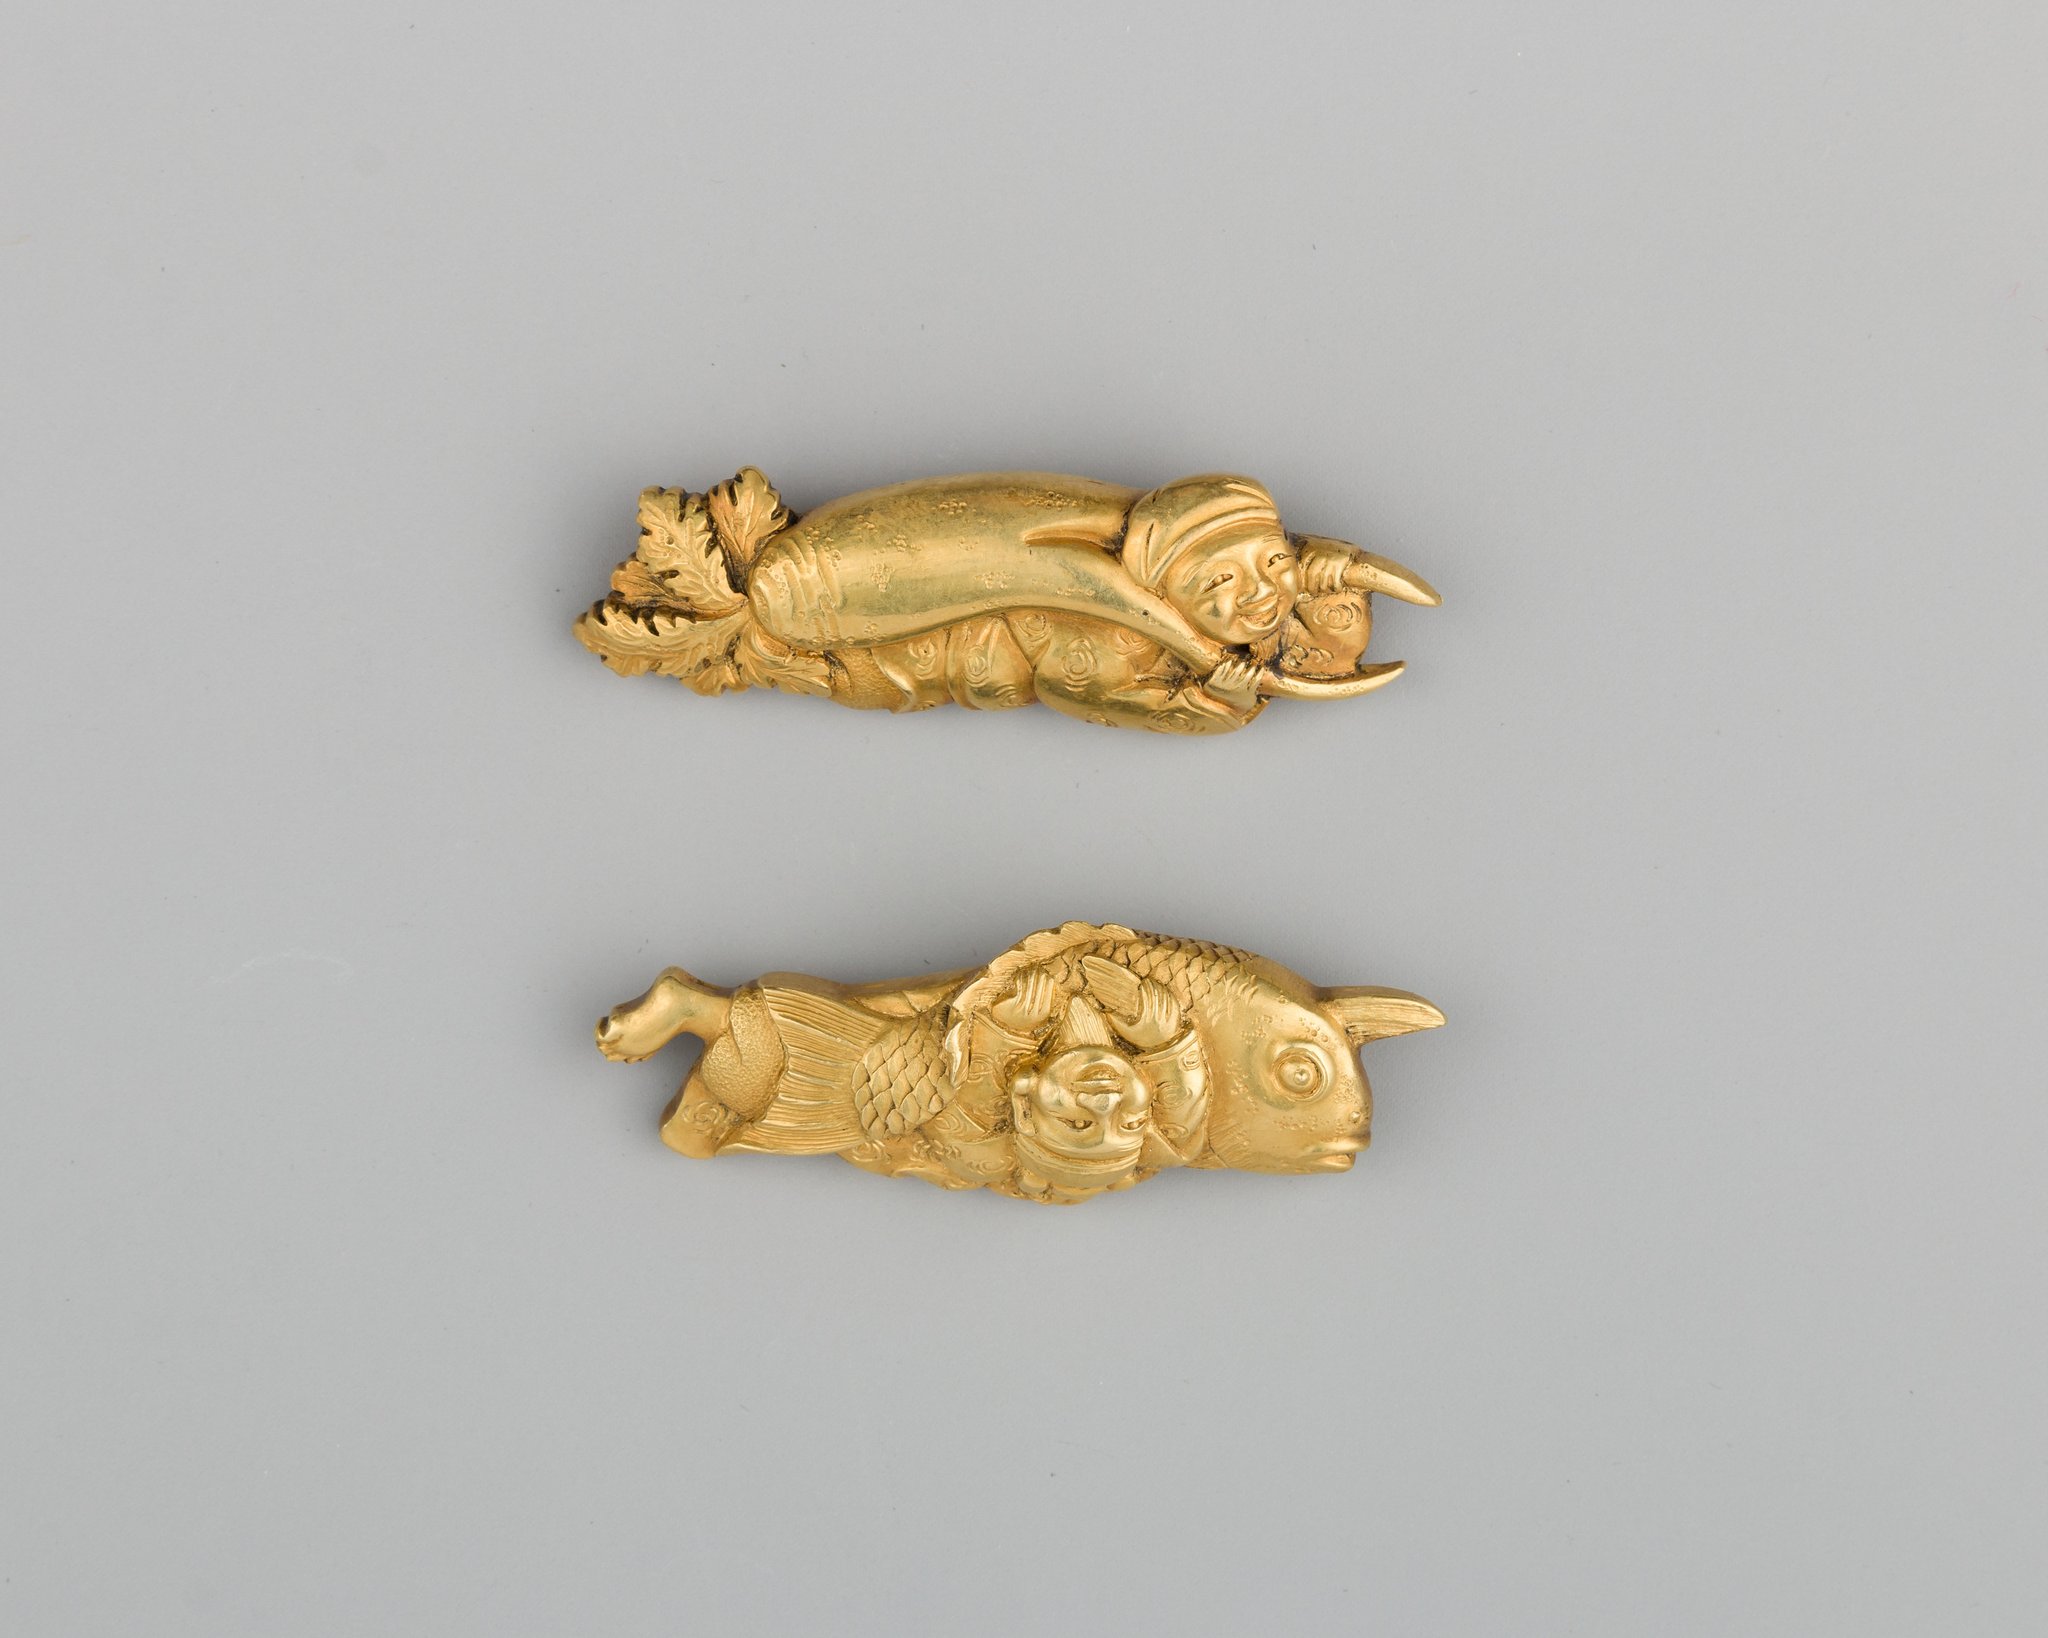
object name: pair of sword grip ornament menuki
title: Pair of Sword-Grip Ornaments (Menuki)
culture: japanese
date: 1701-1800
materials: gold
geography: japan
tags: vegetables,men,fish